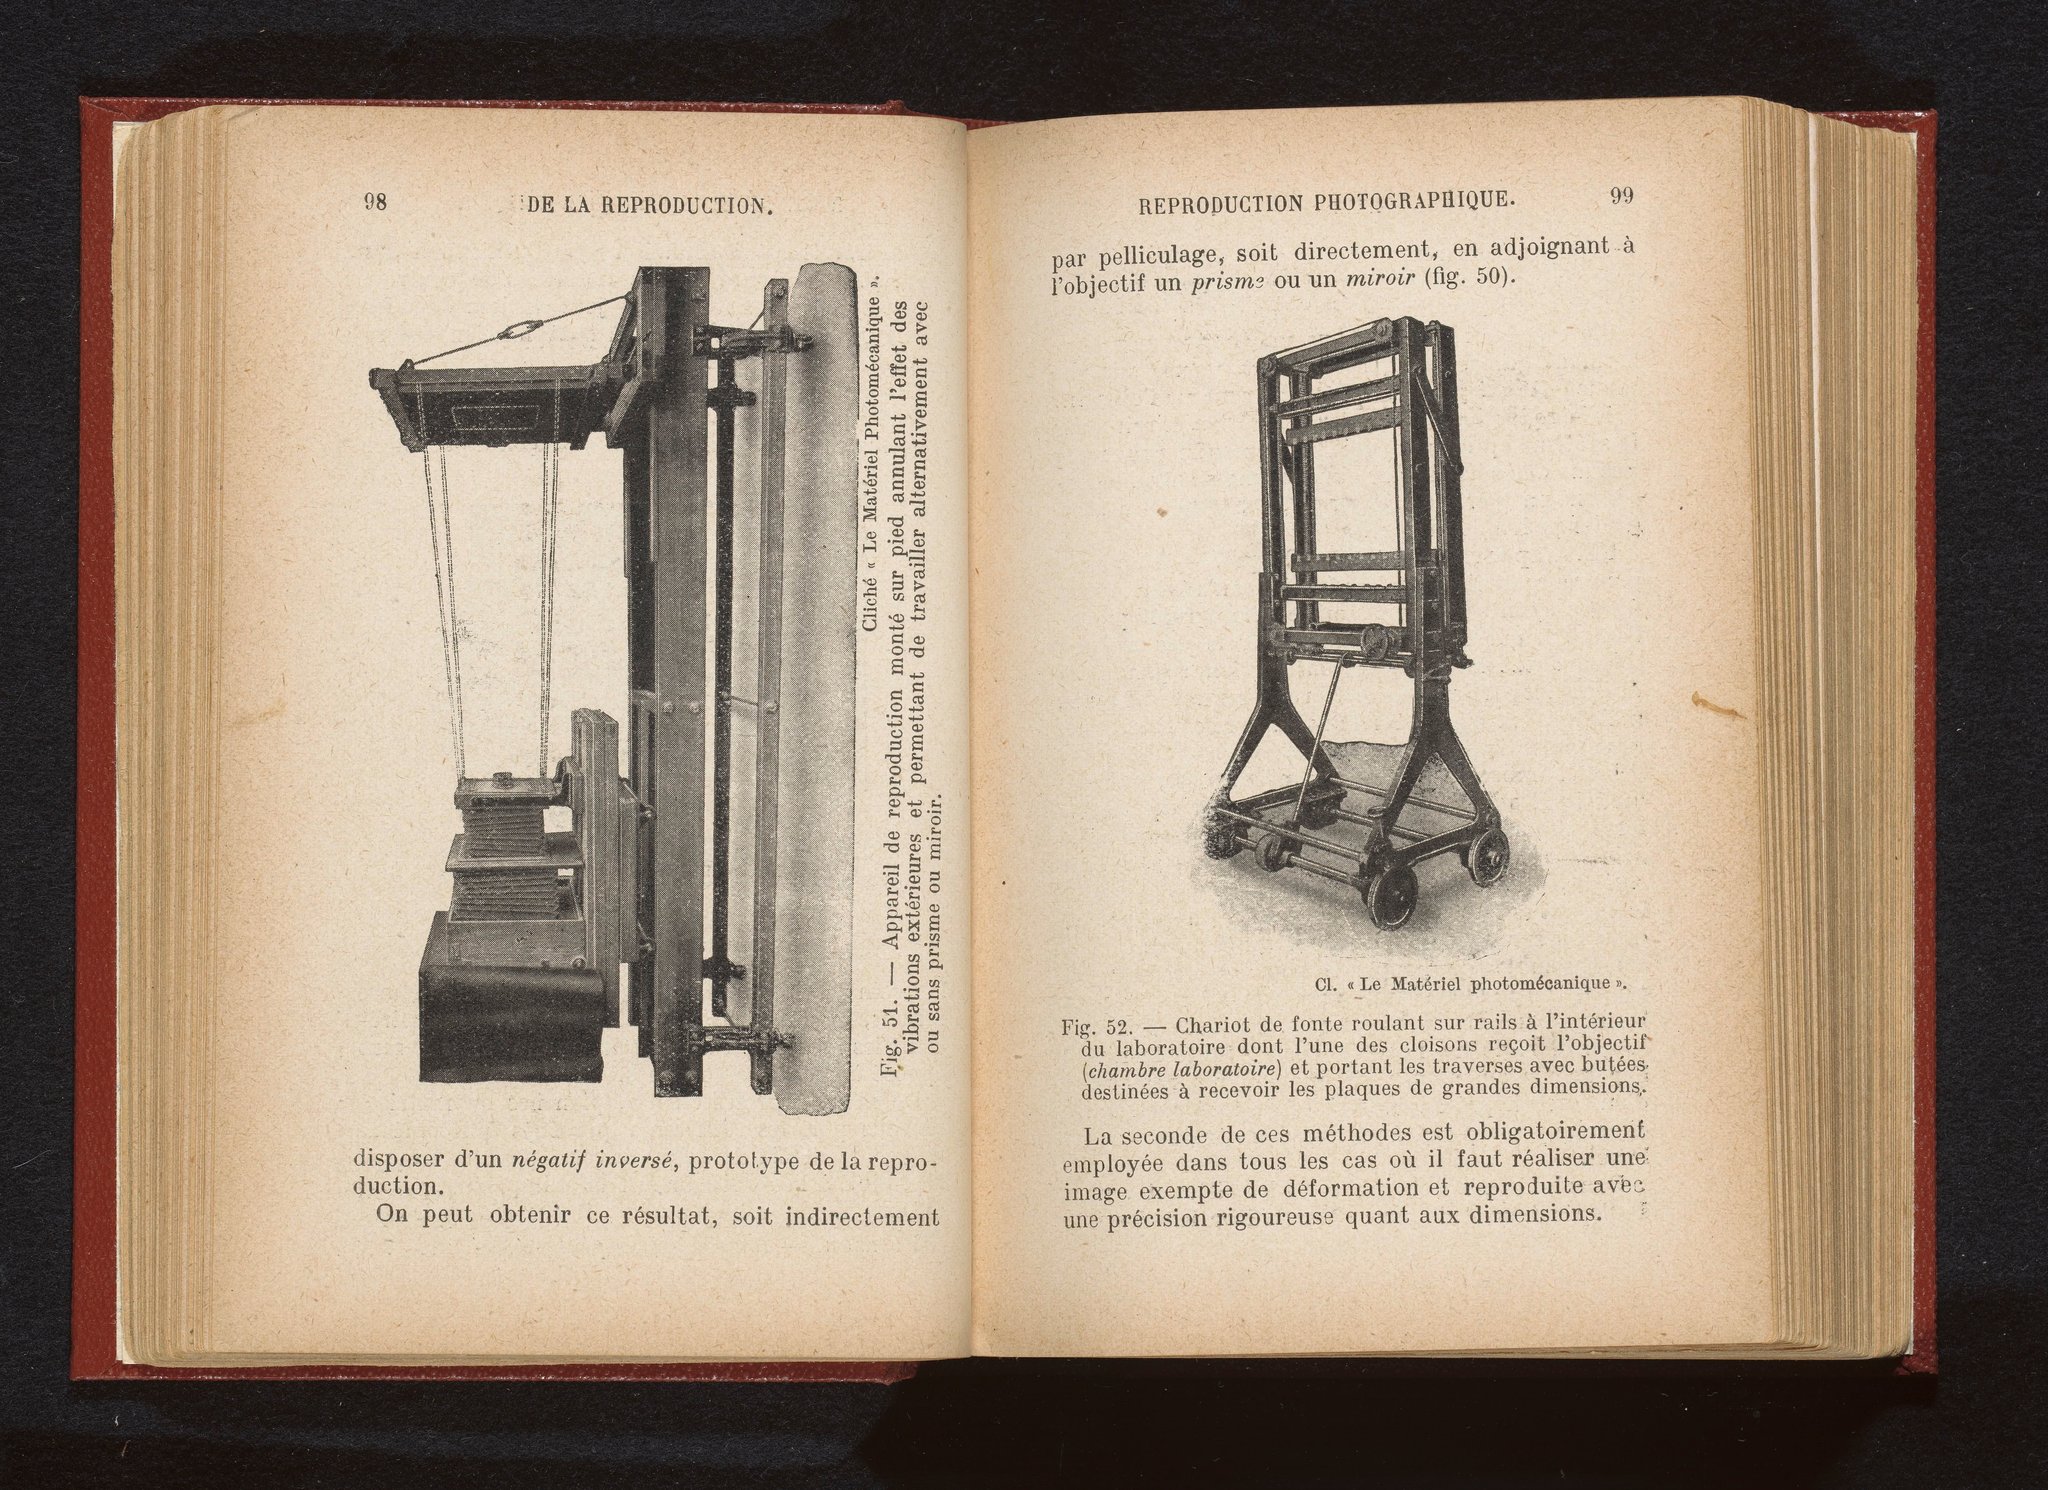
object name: photomechanical print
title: Stellage waarin vermoedelijk iets gemonteerd kan worden dat fotomechanisch gereproduceerd wordt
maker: Anonymous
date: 1922-1932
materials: paper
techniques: autotype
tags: photographic apparatus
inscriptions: number: ‘Fig. 52.’